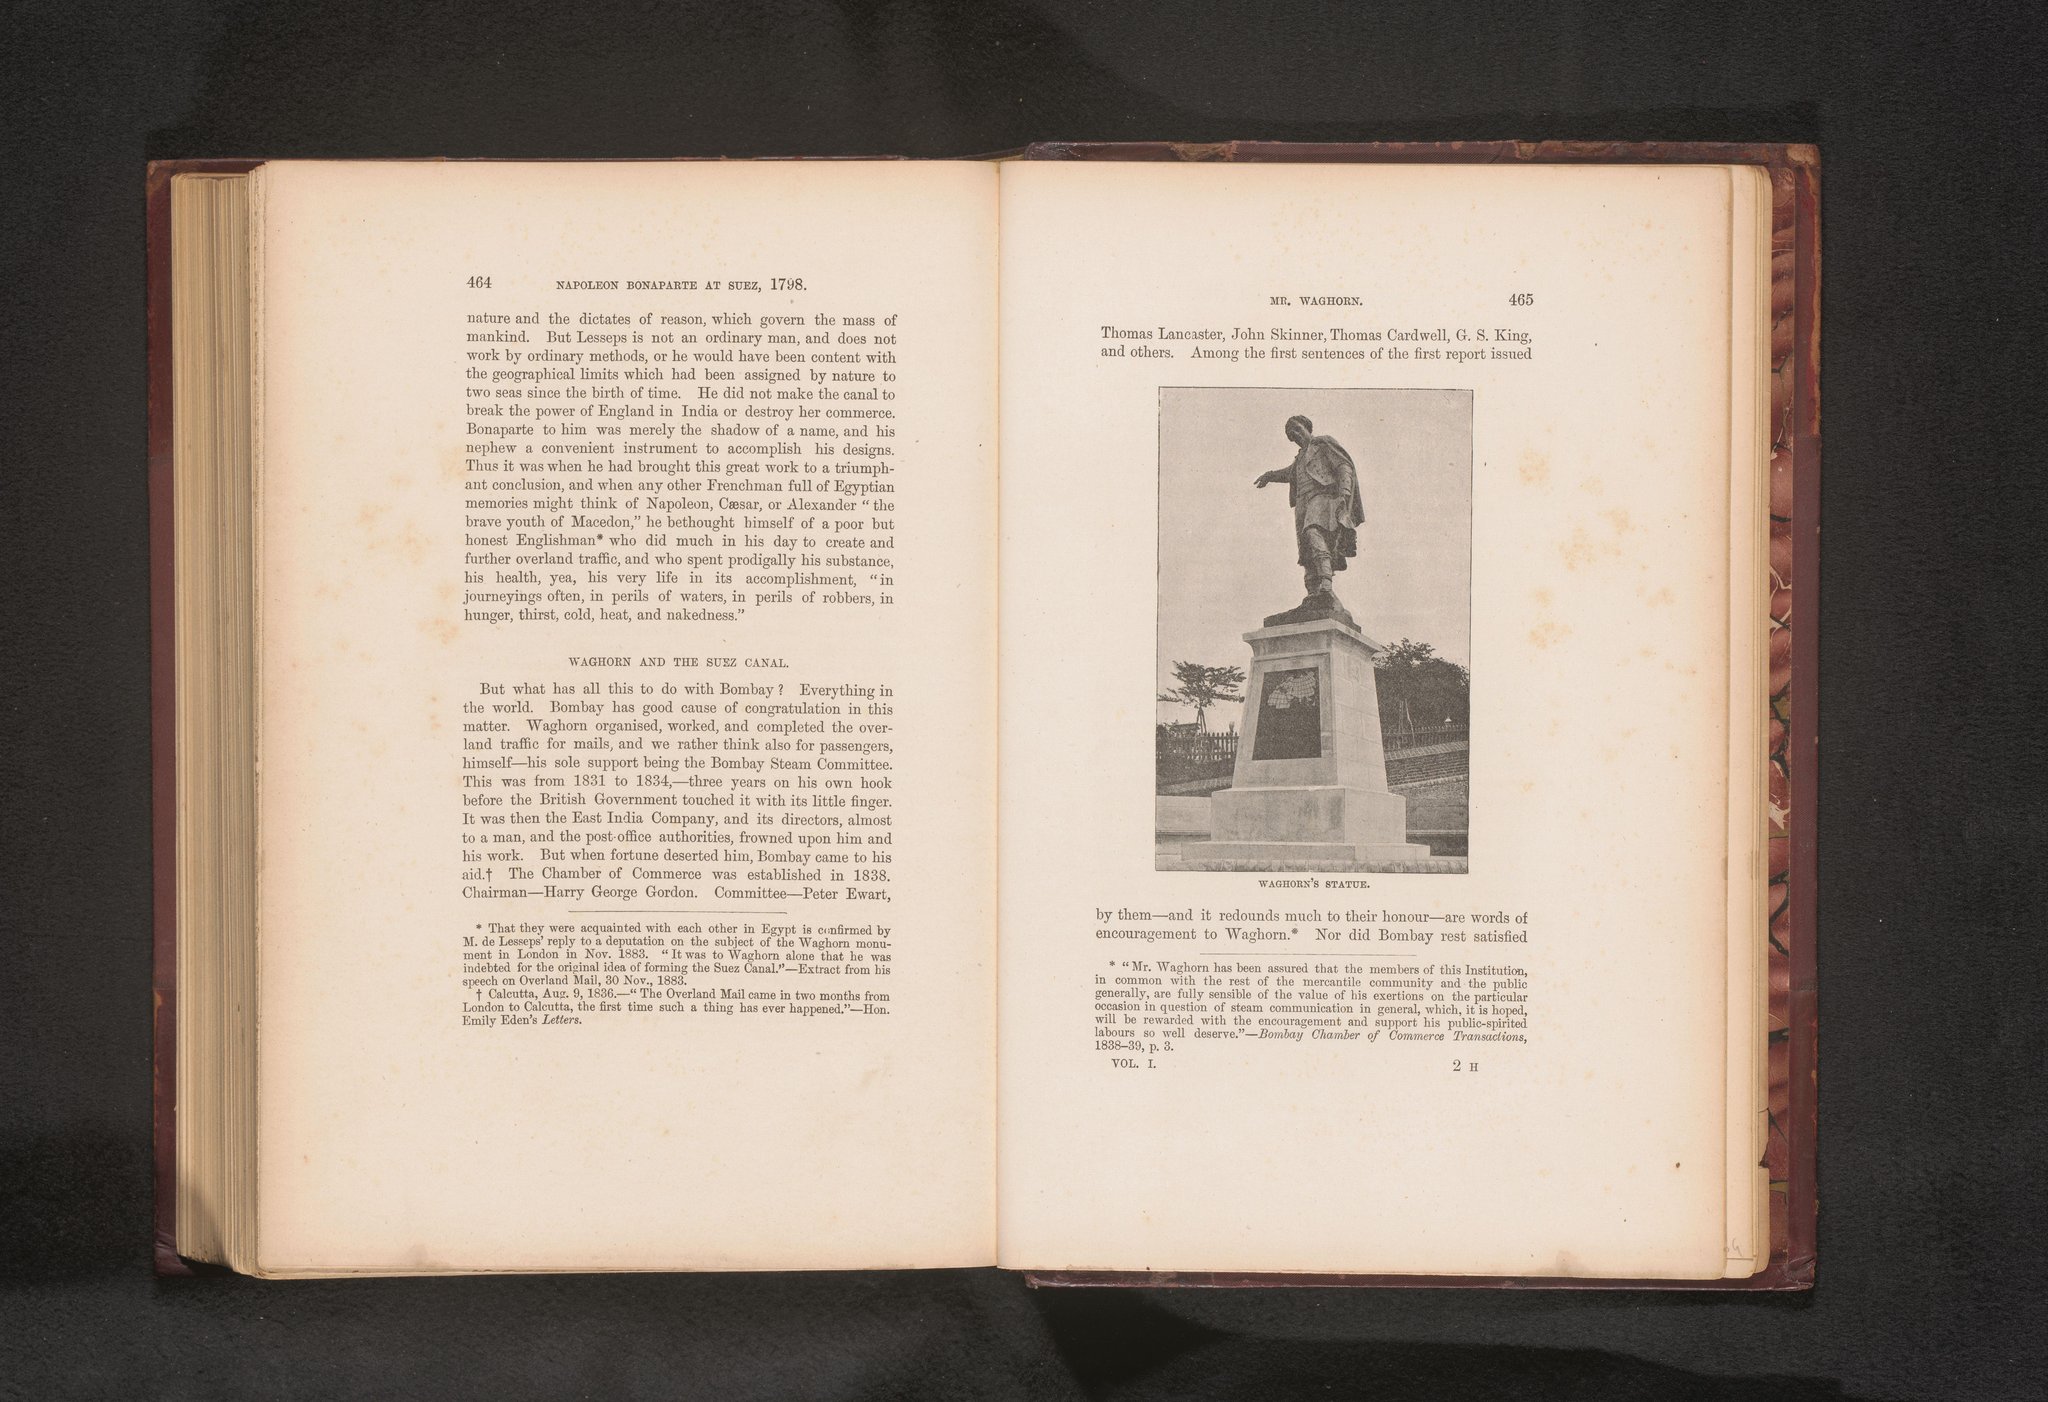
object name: photomechanical print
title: Waghorn's statue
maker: Anonymous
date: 1883-1893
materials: paper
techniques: autotype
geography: paris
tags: sculpture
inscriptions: caption: ‘WAGHORN'S STATUE.’